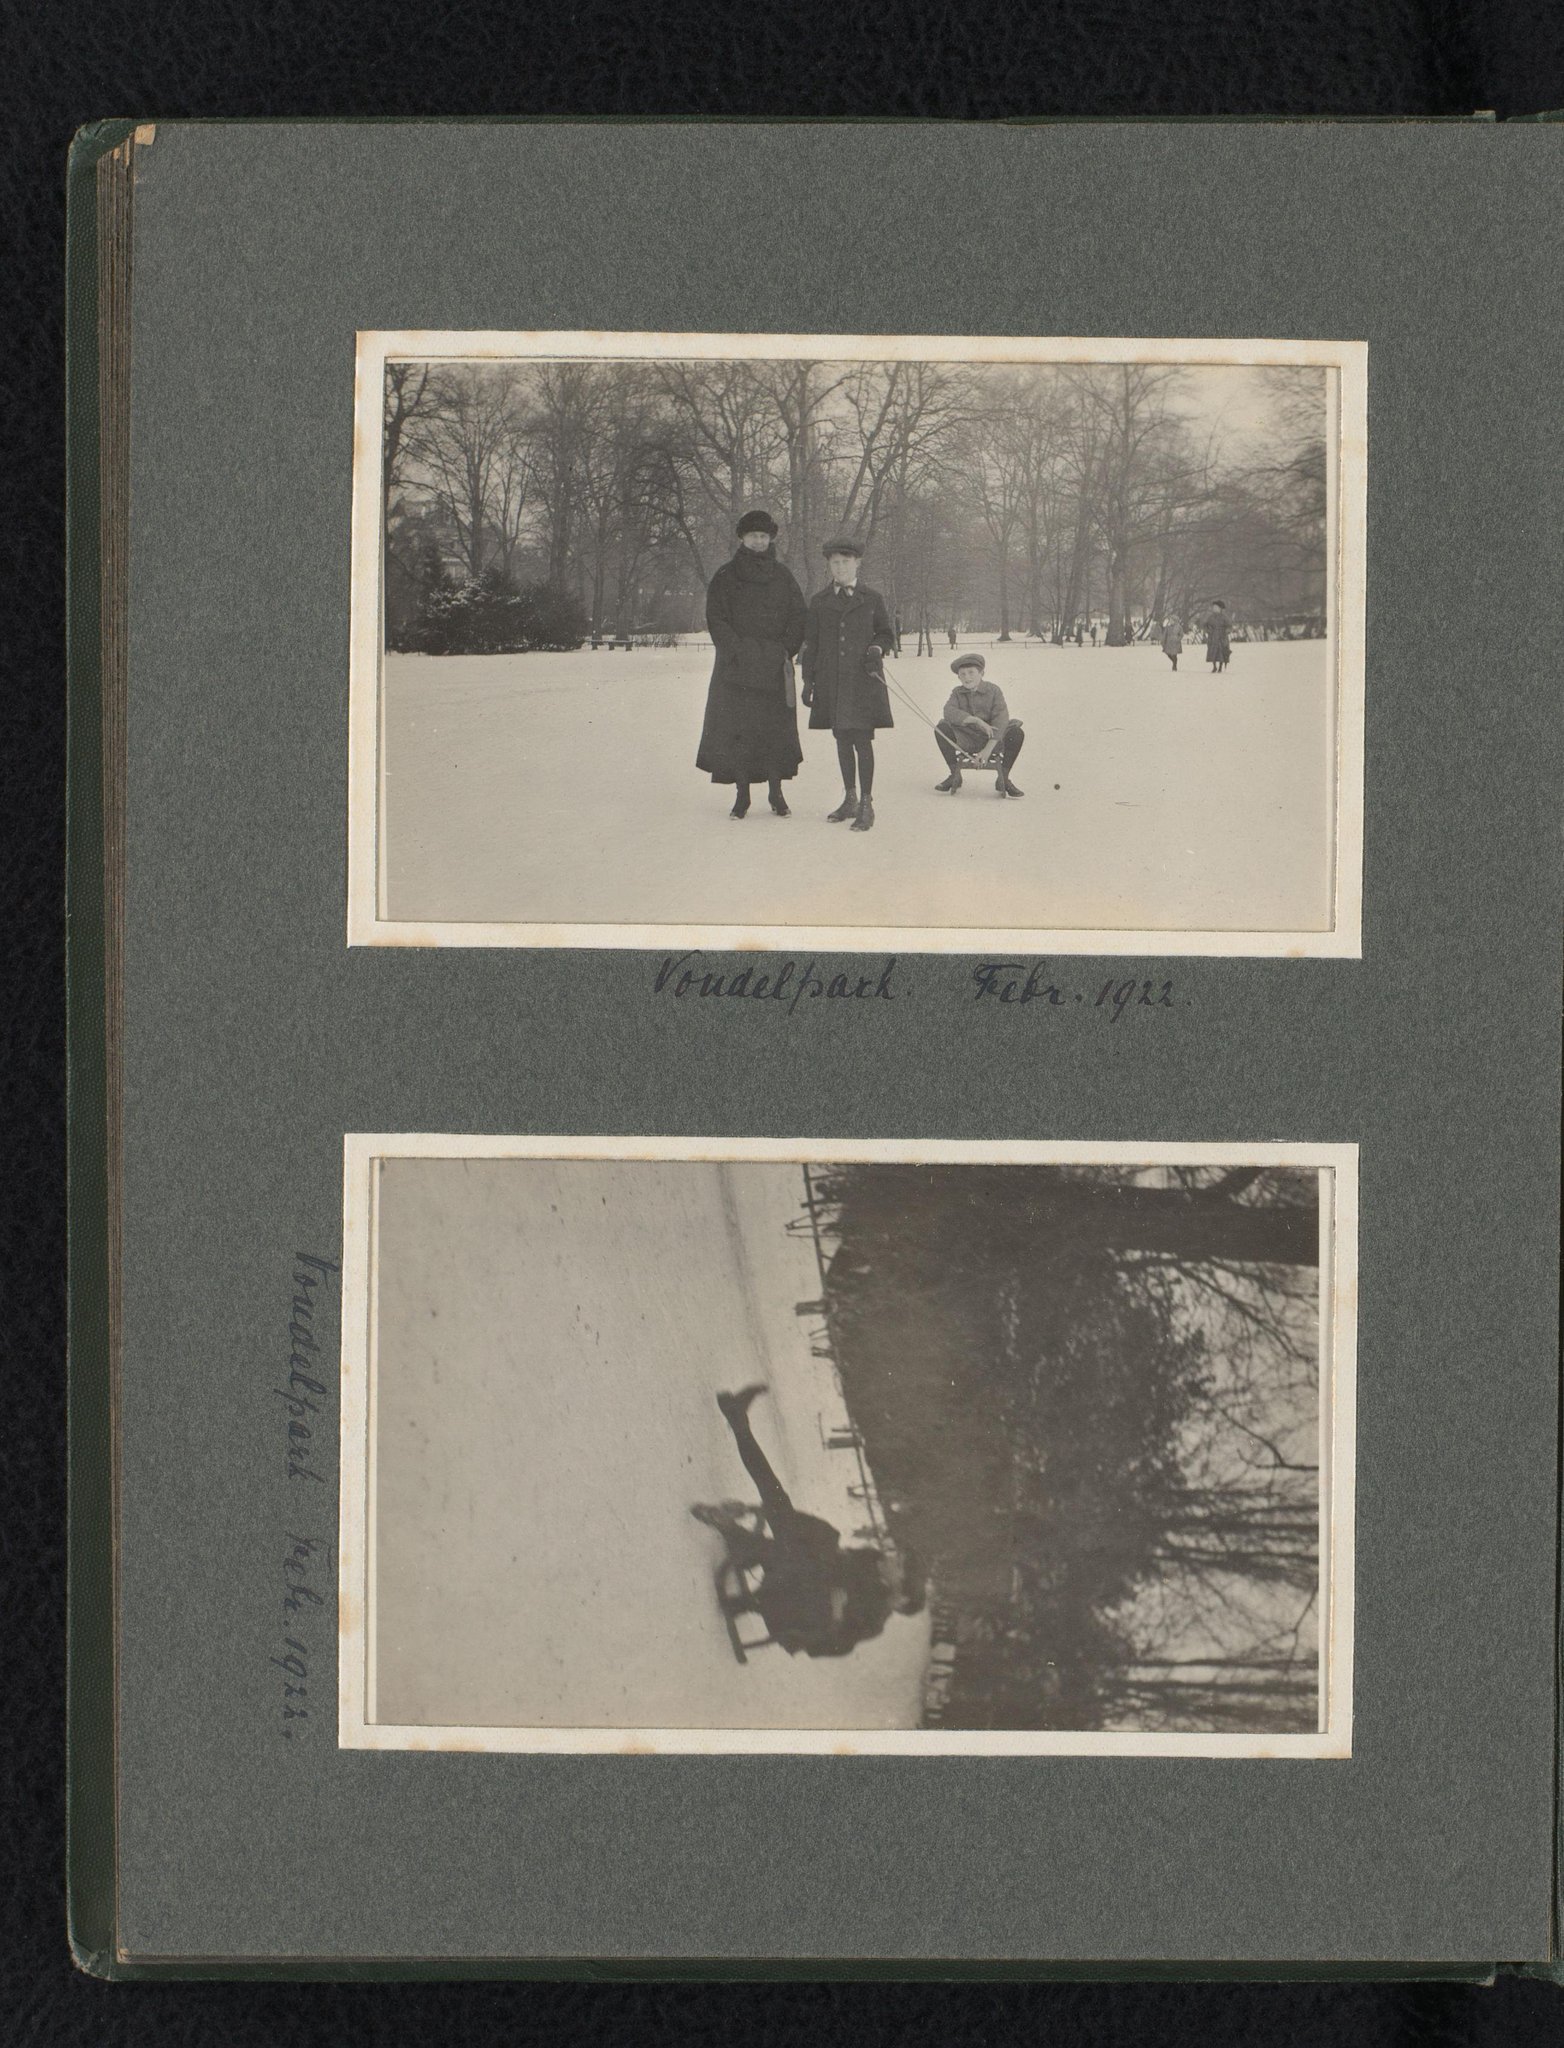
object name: album leaf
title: Twee foto's van leden van familie Van den Berg met een slee in het Vondelpark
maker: hendrik herman van den berg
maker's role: amateurfotograaf, jurist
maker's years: 1875-1944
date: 1902-1922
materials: paper, cardboard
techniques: gelatin silver print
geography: amsterdam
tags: historical persons, sleigh, sledge (non-sport), snow, public gardens, park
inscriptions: caption: ‘Vondelpark Febr. 1922/ Vondelpark Febr. 1922’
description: Deze foto's maken deel uit van een album.